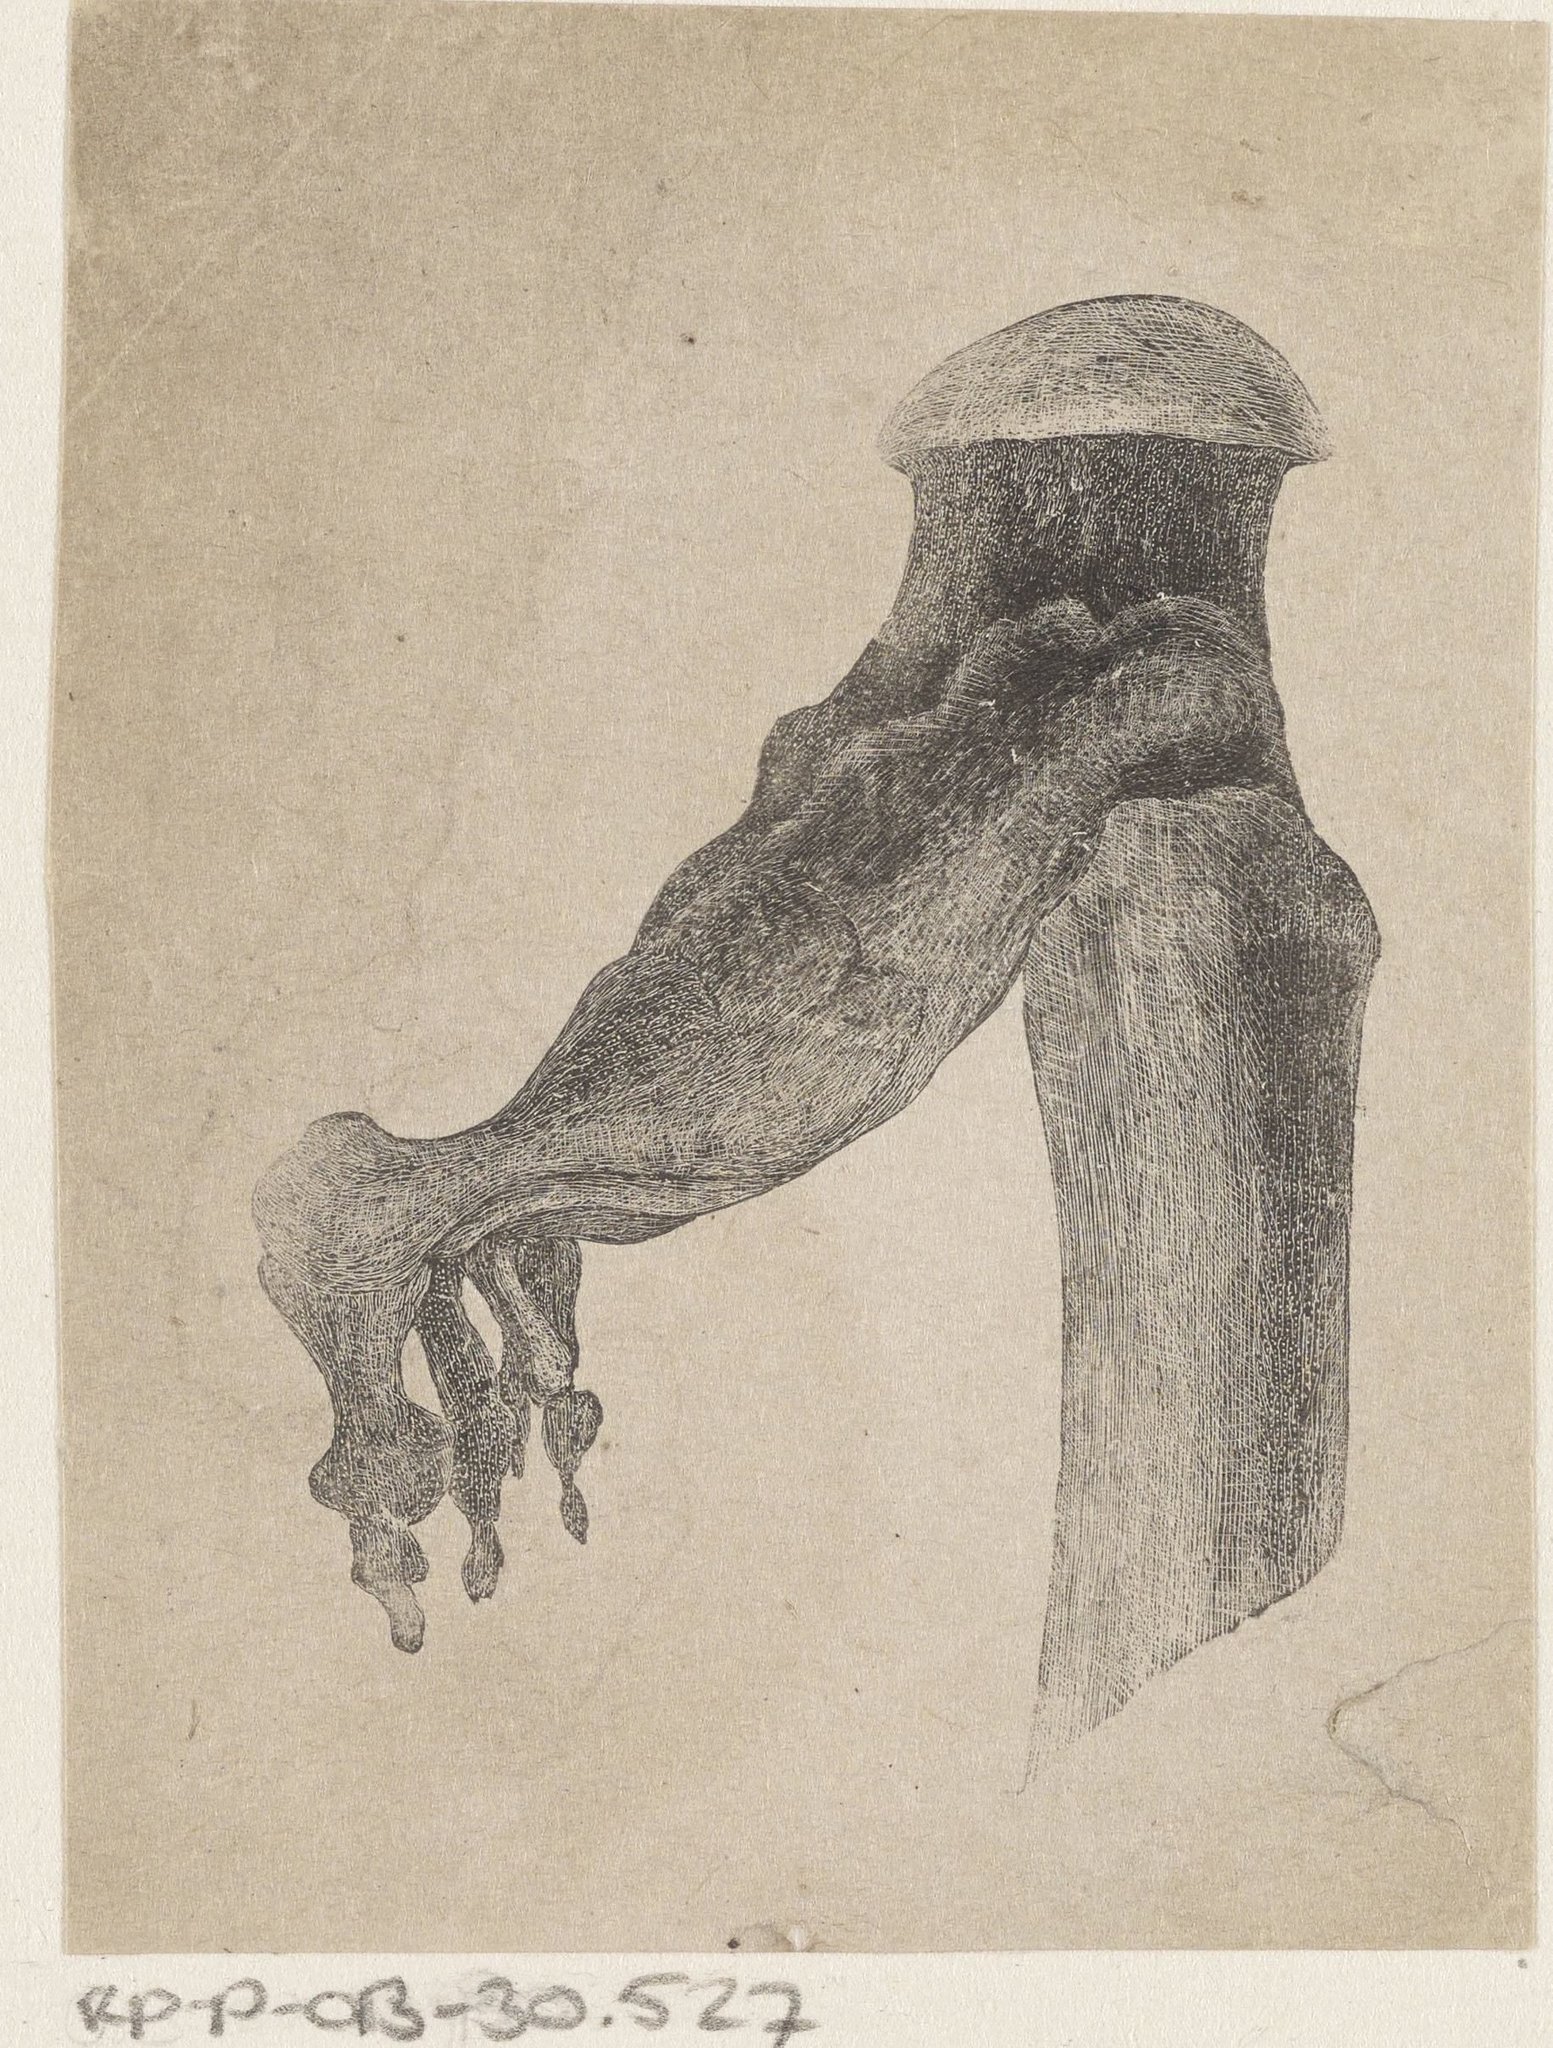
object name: print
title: Menselijk bot met een afwijking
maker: isaac weissenbruch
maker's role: print maker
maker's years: 1826-1912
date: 1836-1912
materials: paper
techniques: engraving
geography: netherlands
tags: bones in general (human body), diseases